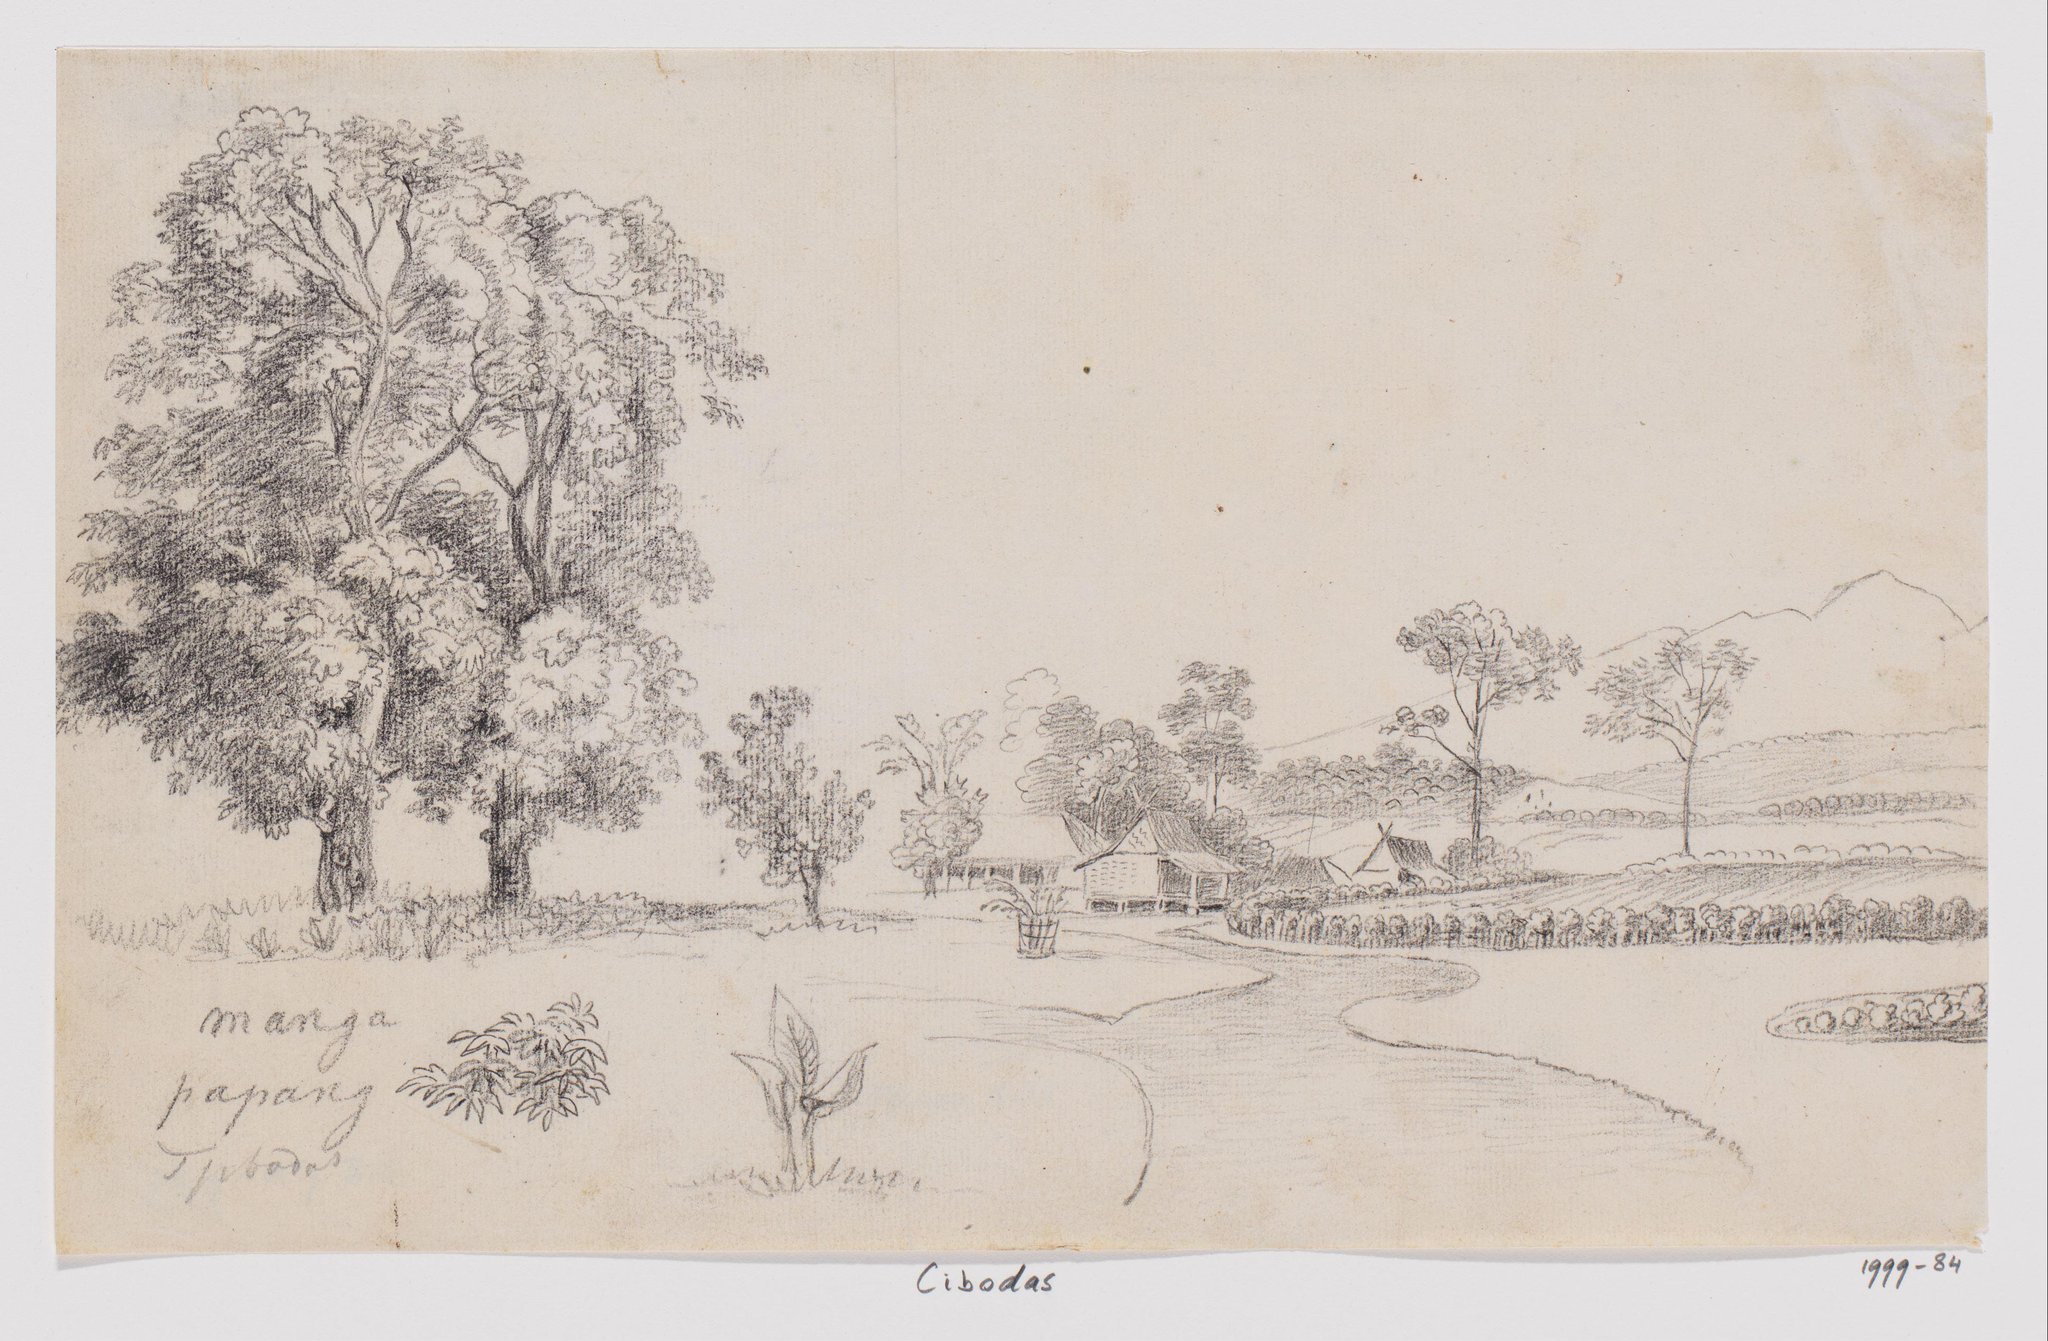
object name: drawing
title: Gezicht te Cibodas met twee mangobomen, West-Java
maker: adrianus johannes bik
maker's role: draughtsman, print maker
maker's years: 1790-1872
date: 1816-1846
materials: chalk, paper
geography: west java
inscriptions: inscription: ‘manga/papang/Tjibodas’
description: artikel over deze collectie in Bulletin van het Rijksmuseum 49 [2001], nr. 4, pp 342 e.v.